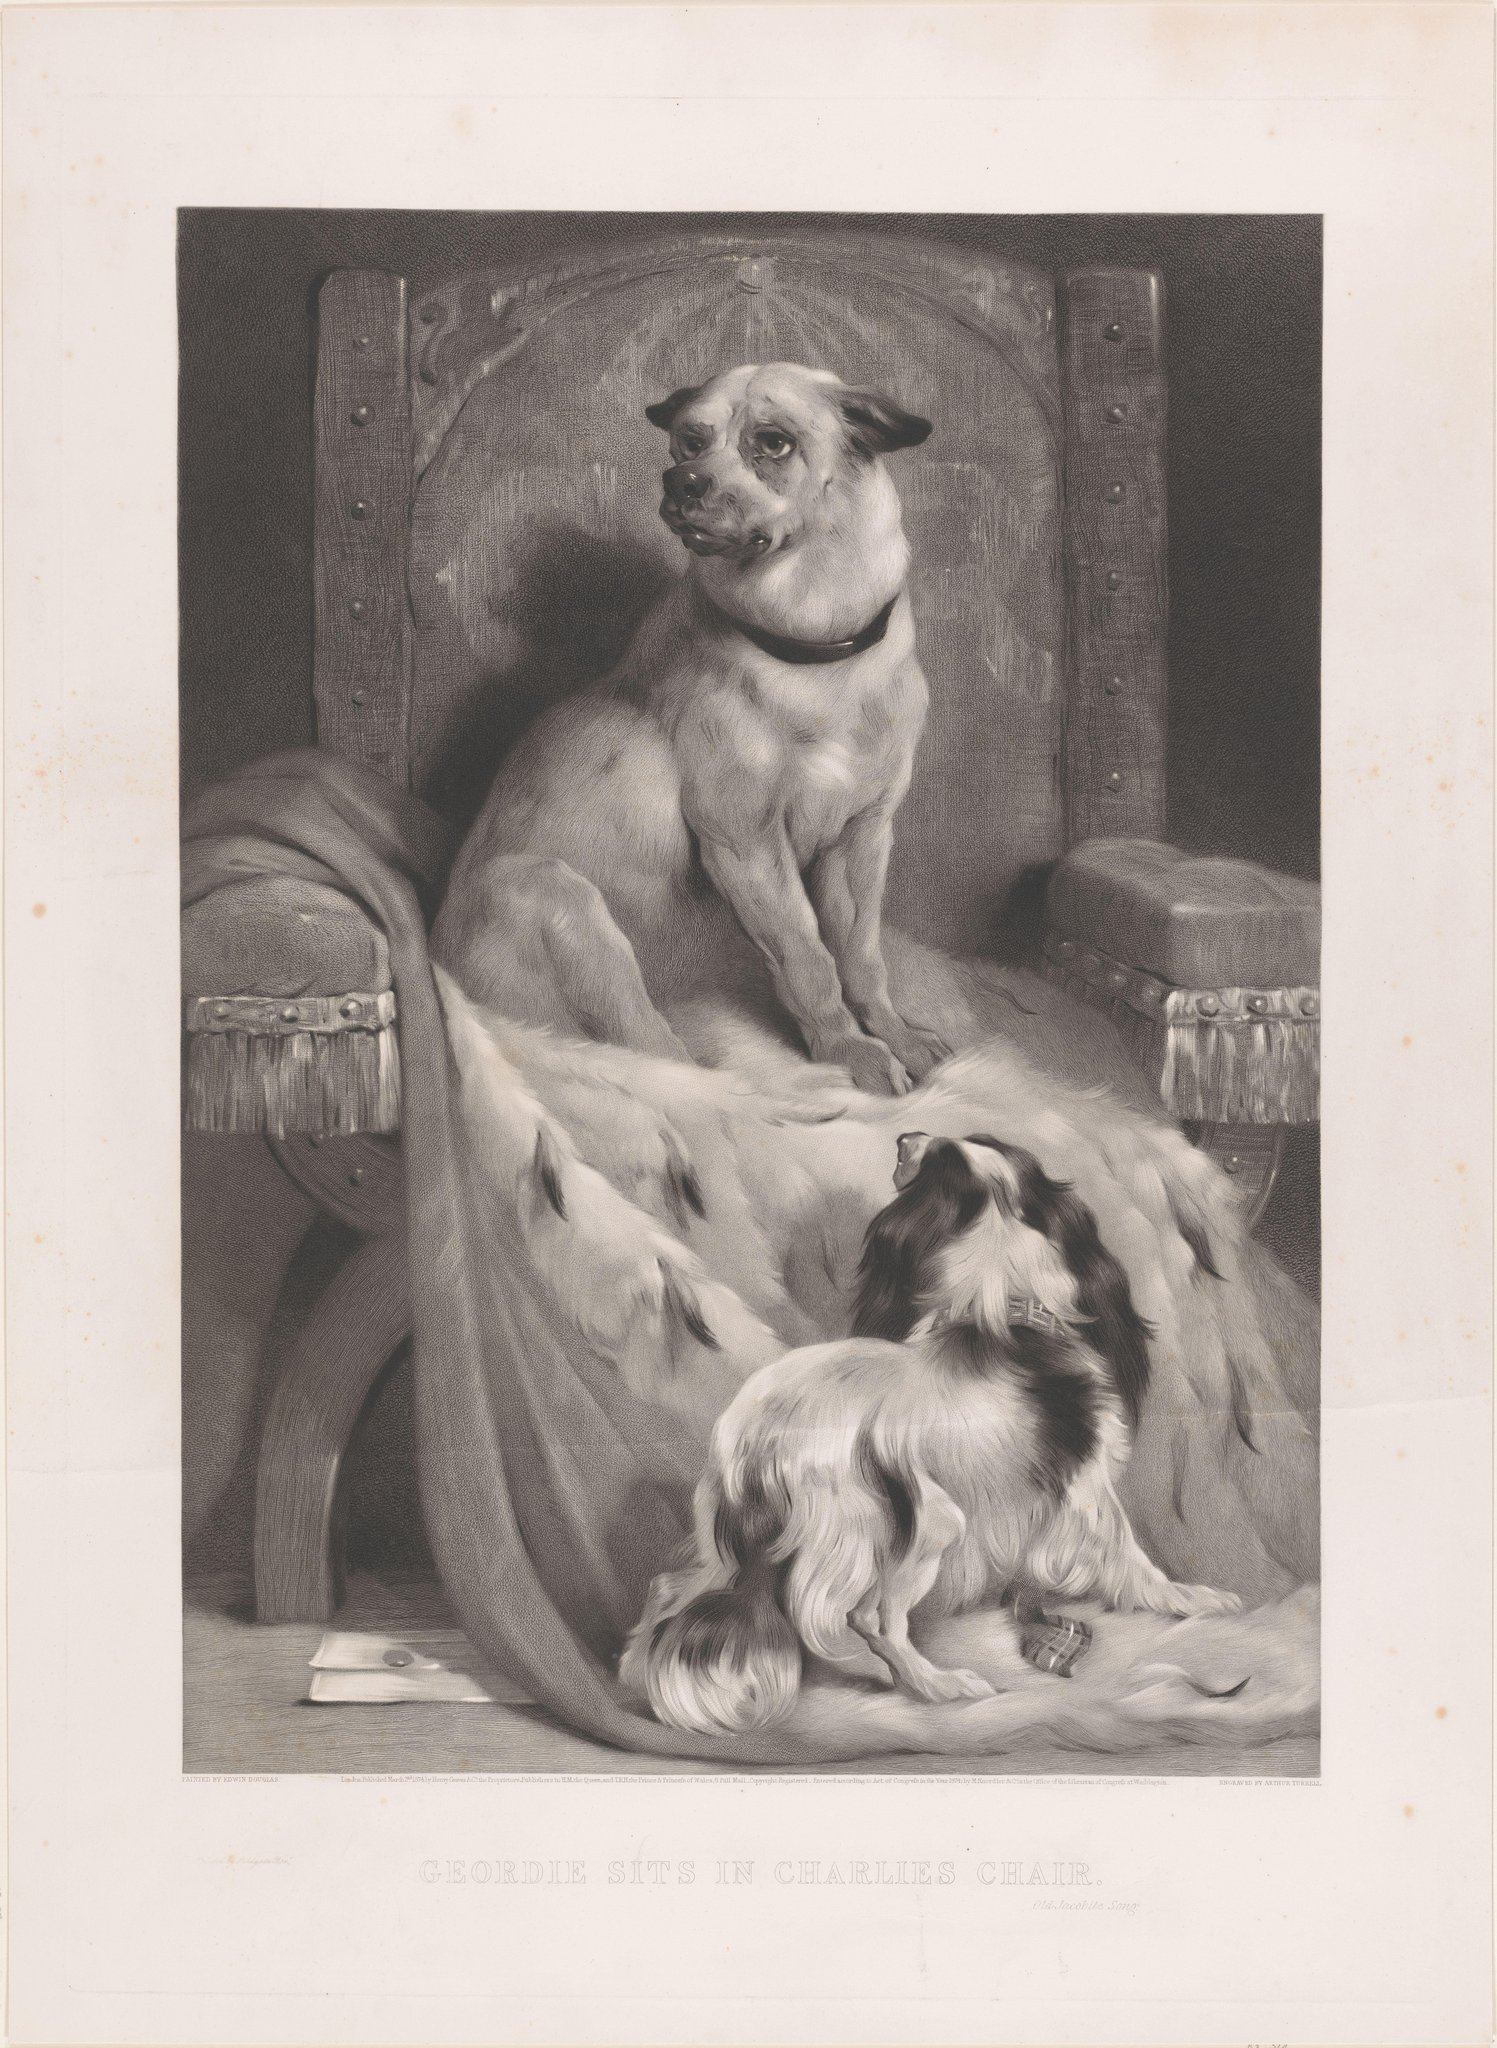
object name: print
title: Geordie sits in Charlies chair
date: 1874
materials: paper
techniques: engraving, etching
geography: london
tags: mutiny, rebellion ~ military discipline, dog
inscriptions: collector's mark: Lugt 2228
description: Op de vorstenzetel een mopshond en voor deze troon een spaniël met een lint van tartan om zijn nek.